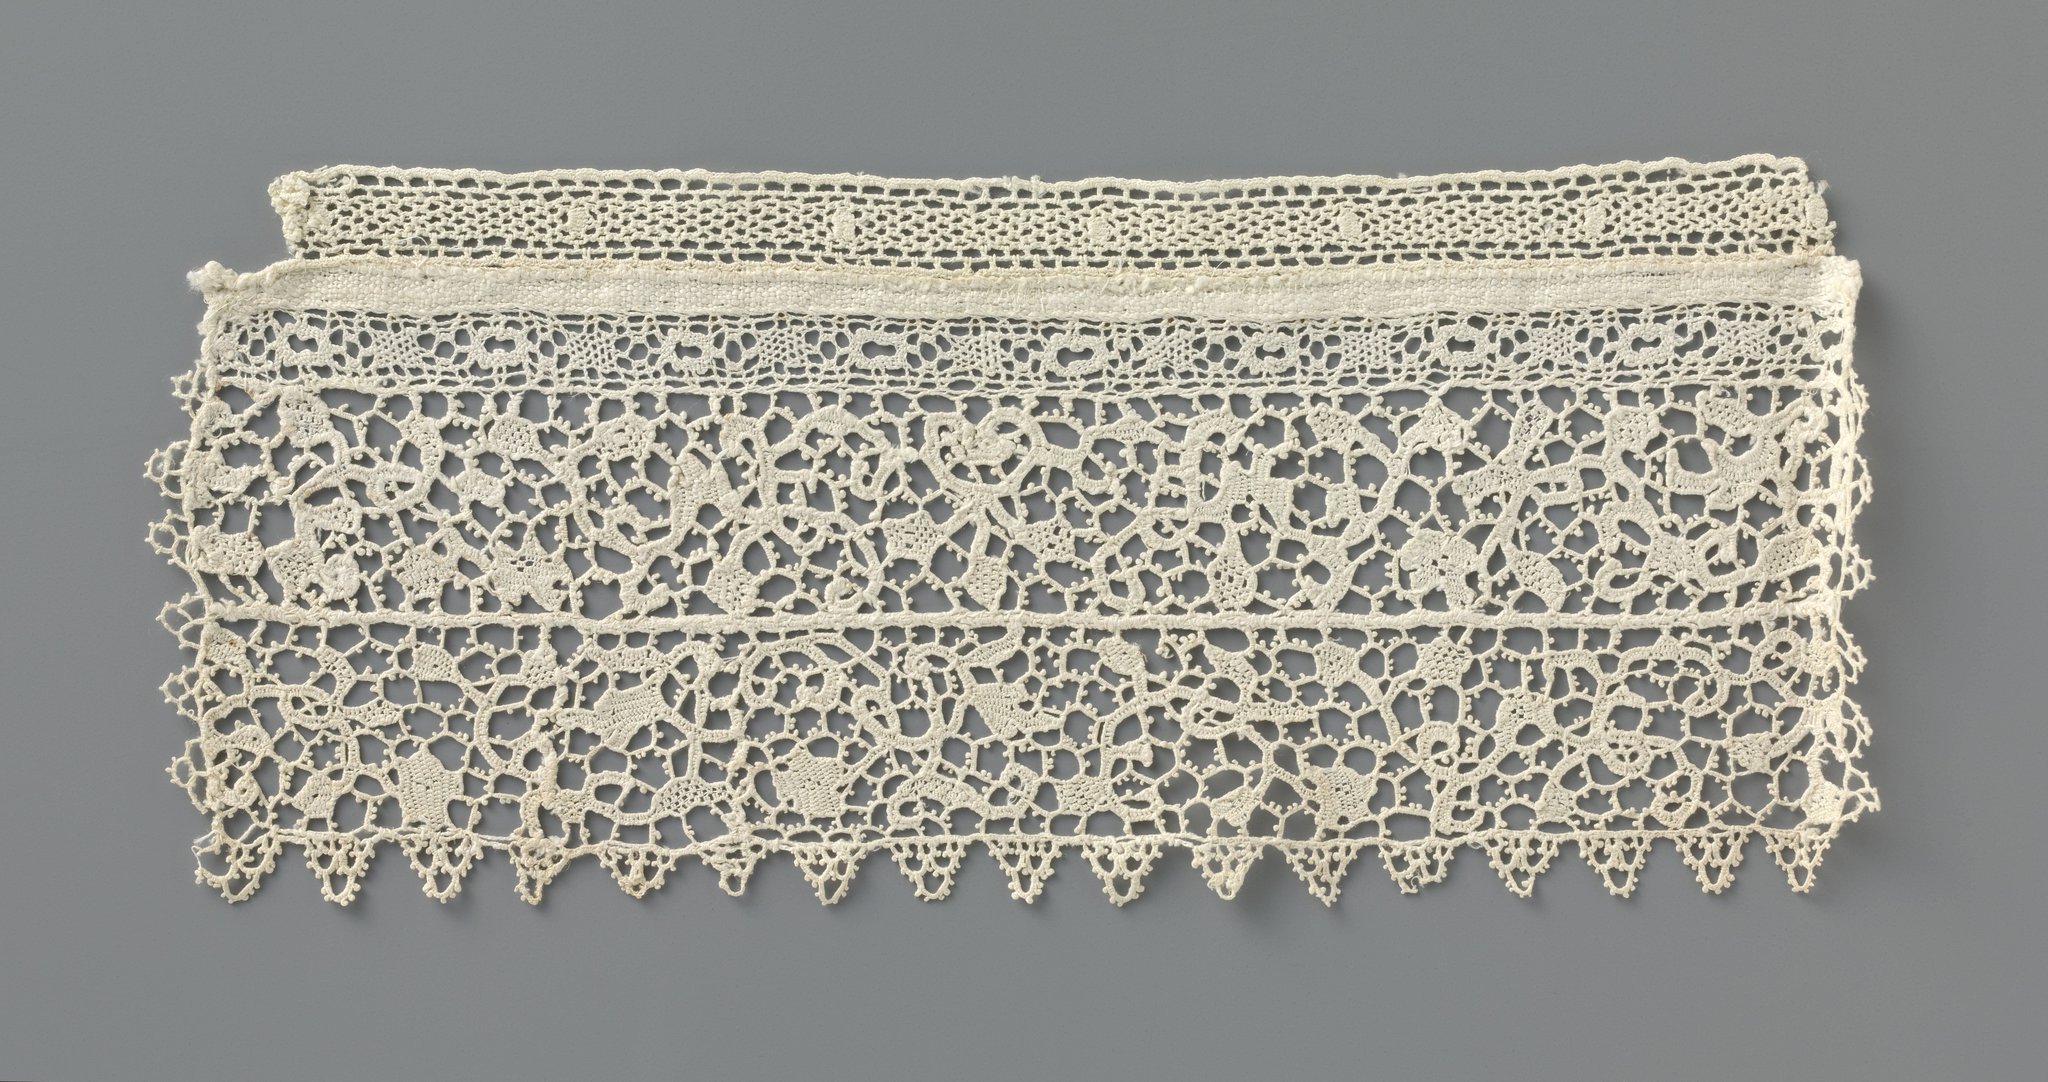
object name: strip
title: Verdubbelde strook naaldkant met hartvormige rankjes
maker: Anonymous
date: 1690-1699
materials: linen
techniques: flat venetian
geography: venice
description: Verjaarsgeschenk van Koningin Wilhelmina, 2 augustus 1908. Werd in 1929 gedragen door Konining Emma op de familiefoto van 'Koningin Wilhelmina met Moeder en Dochter'. De hier beschreven strook is één van de zes delen van een strook die in totaal 130 x 7 cm van afmeting is.